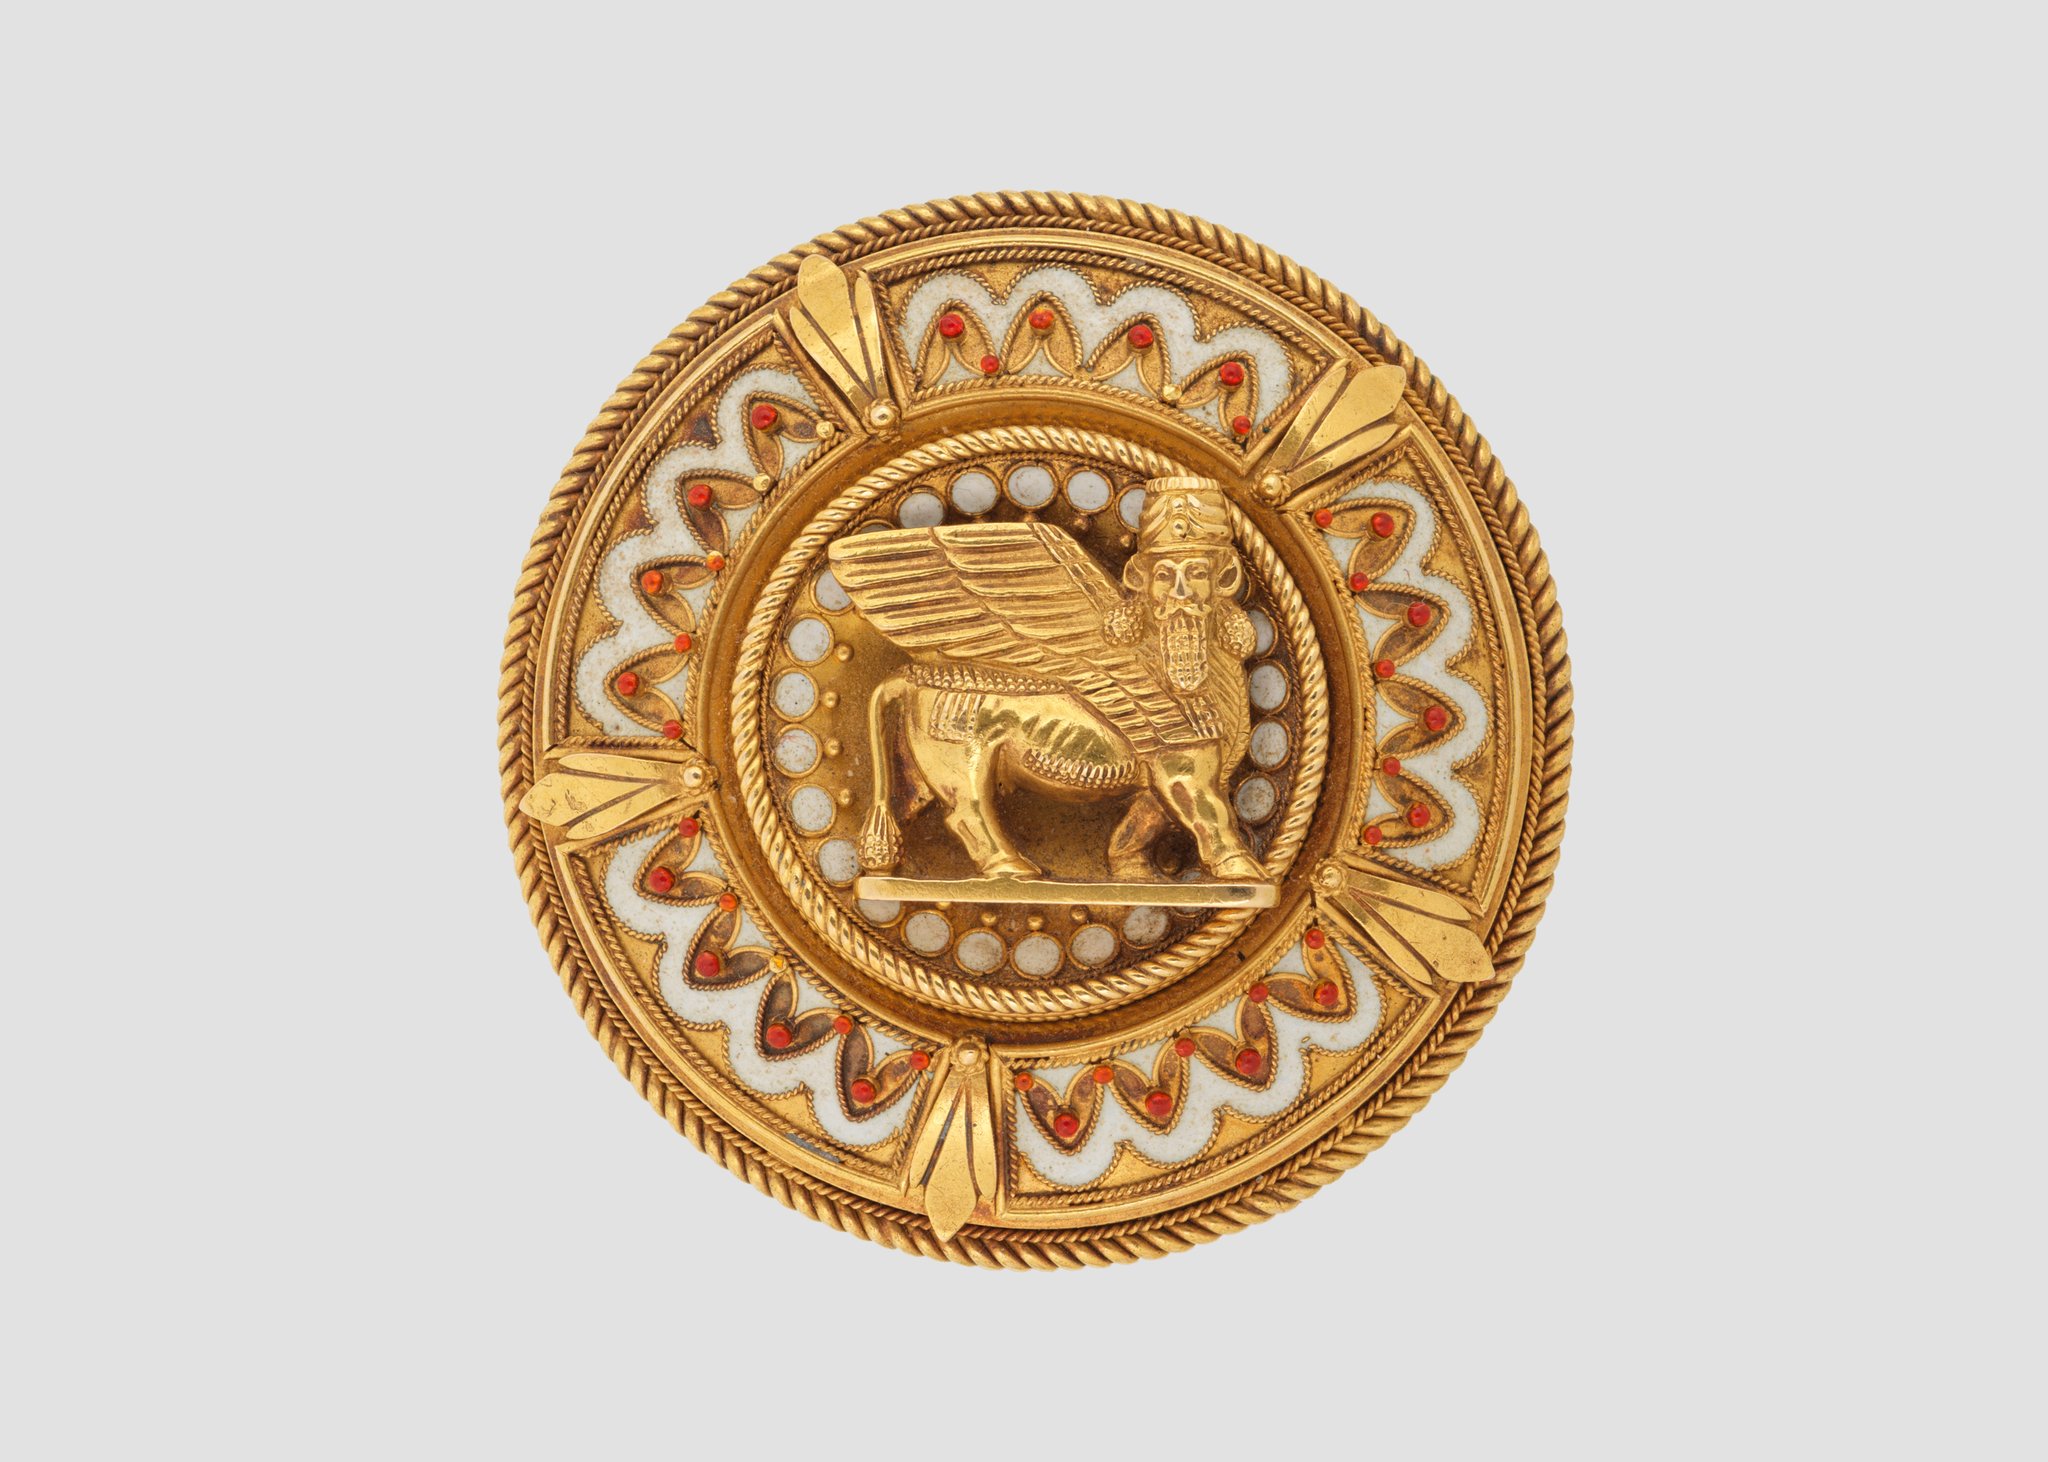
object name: brooch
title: Brooch with Assyrian human-headed winged bull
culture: british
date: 1873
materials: enamel, glass, gold